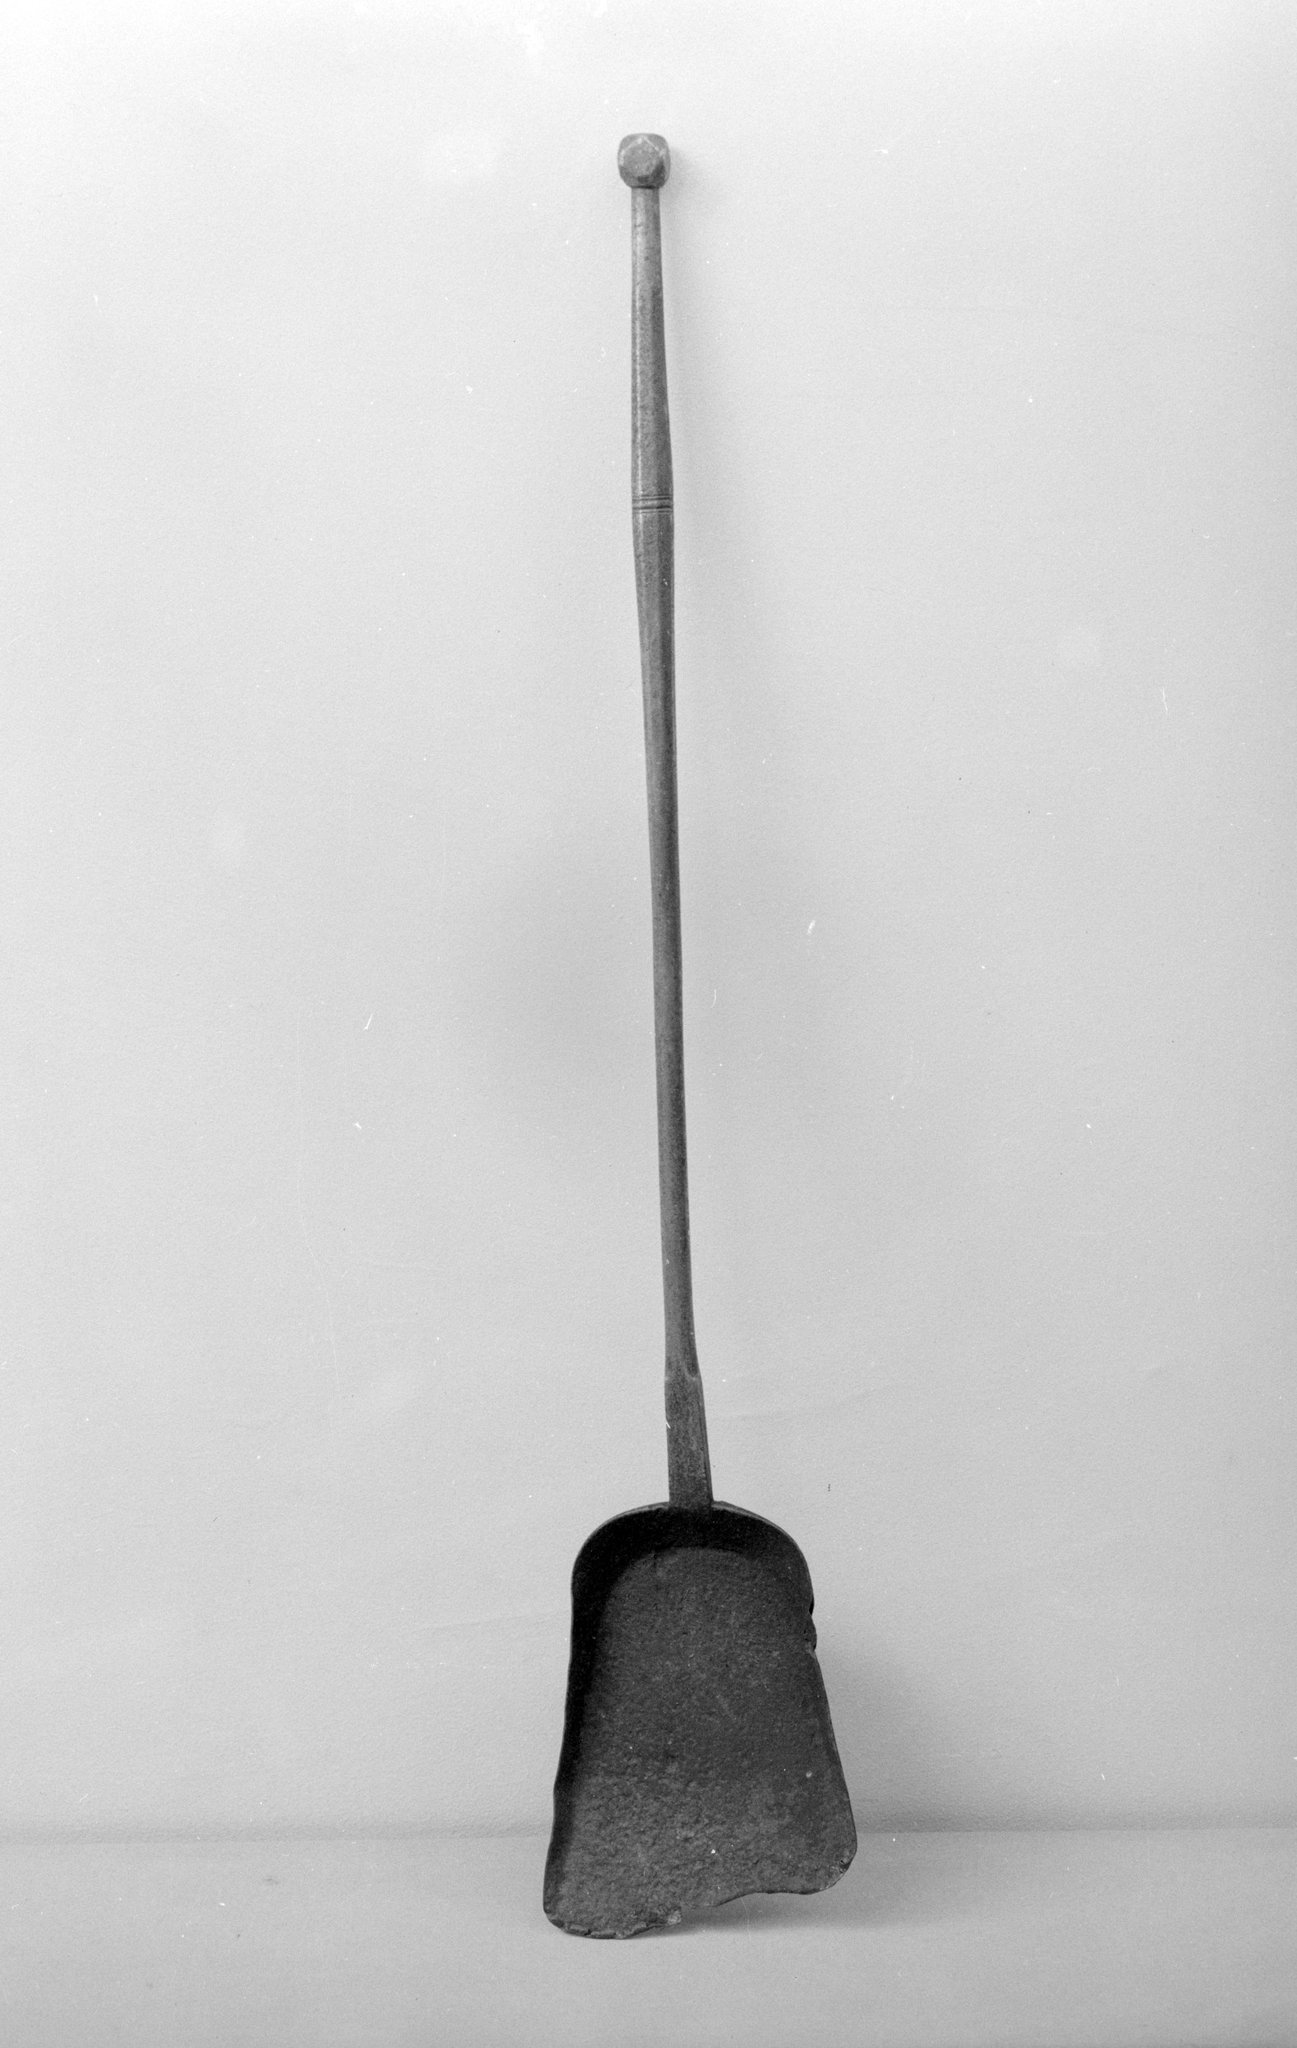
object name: shovel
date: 1701-1800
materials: iron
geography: england